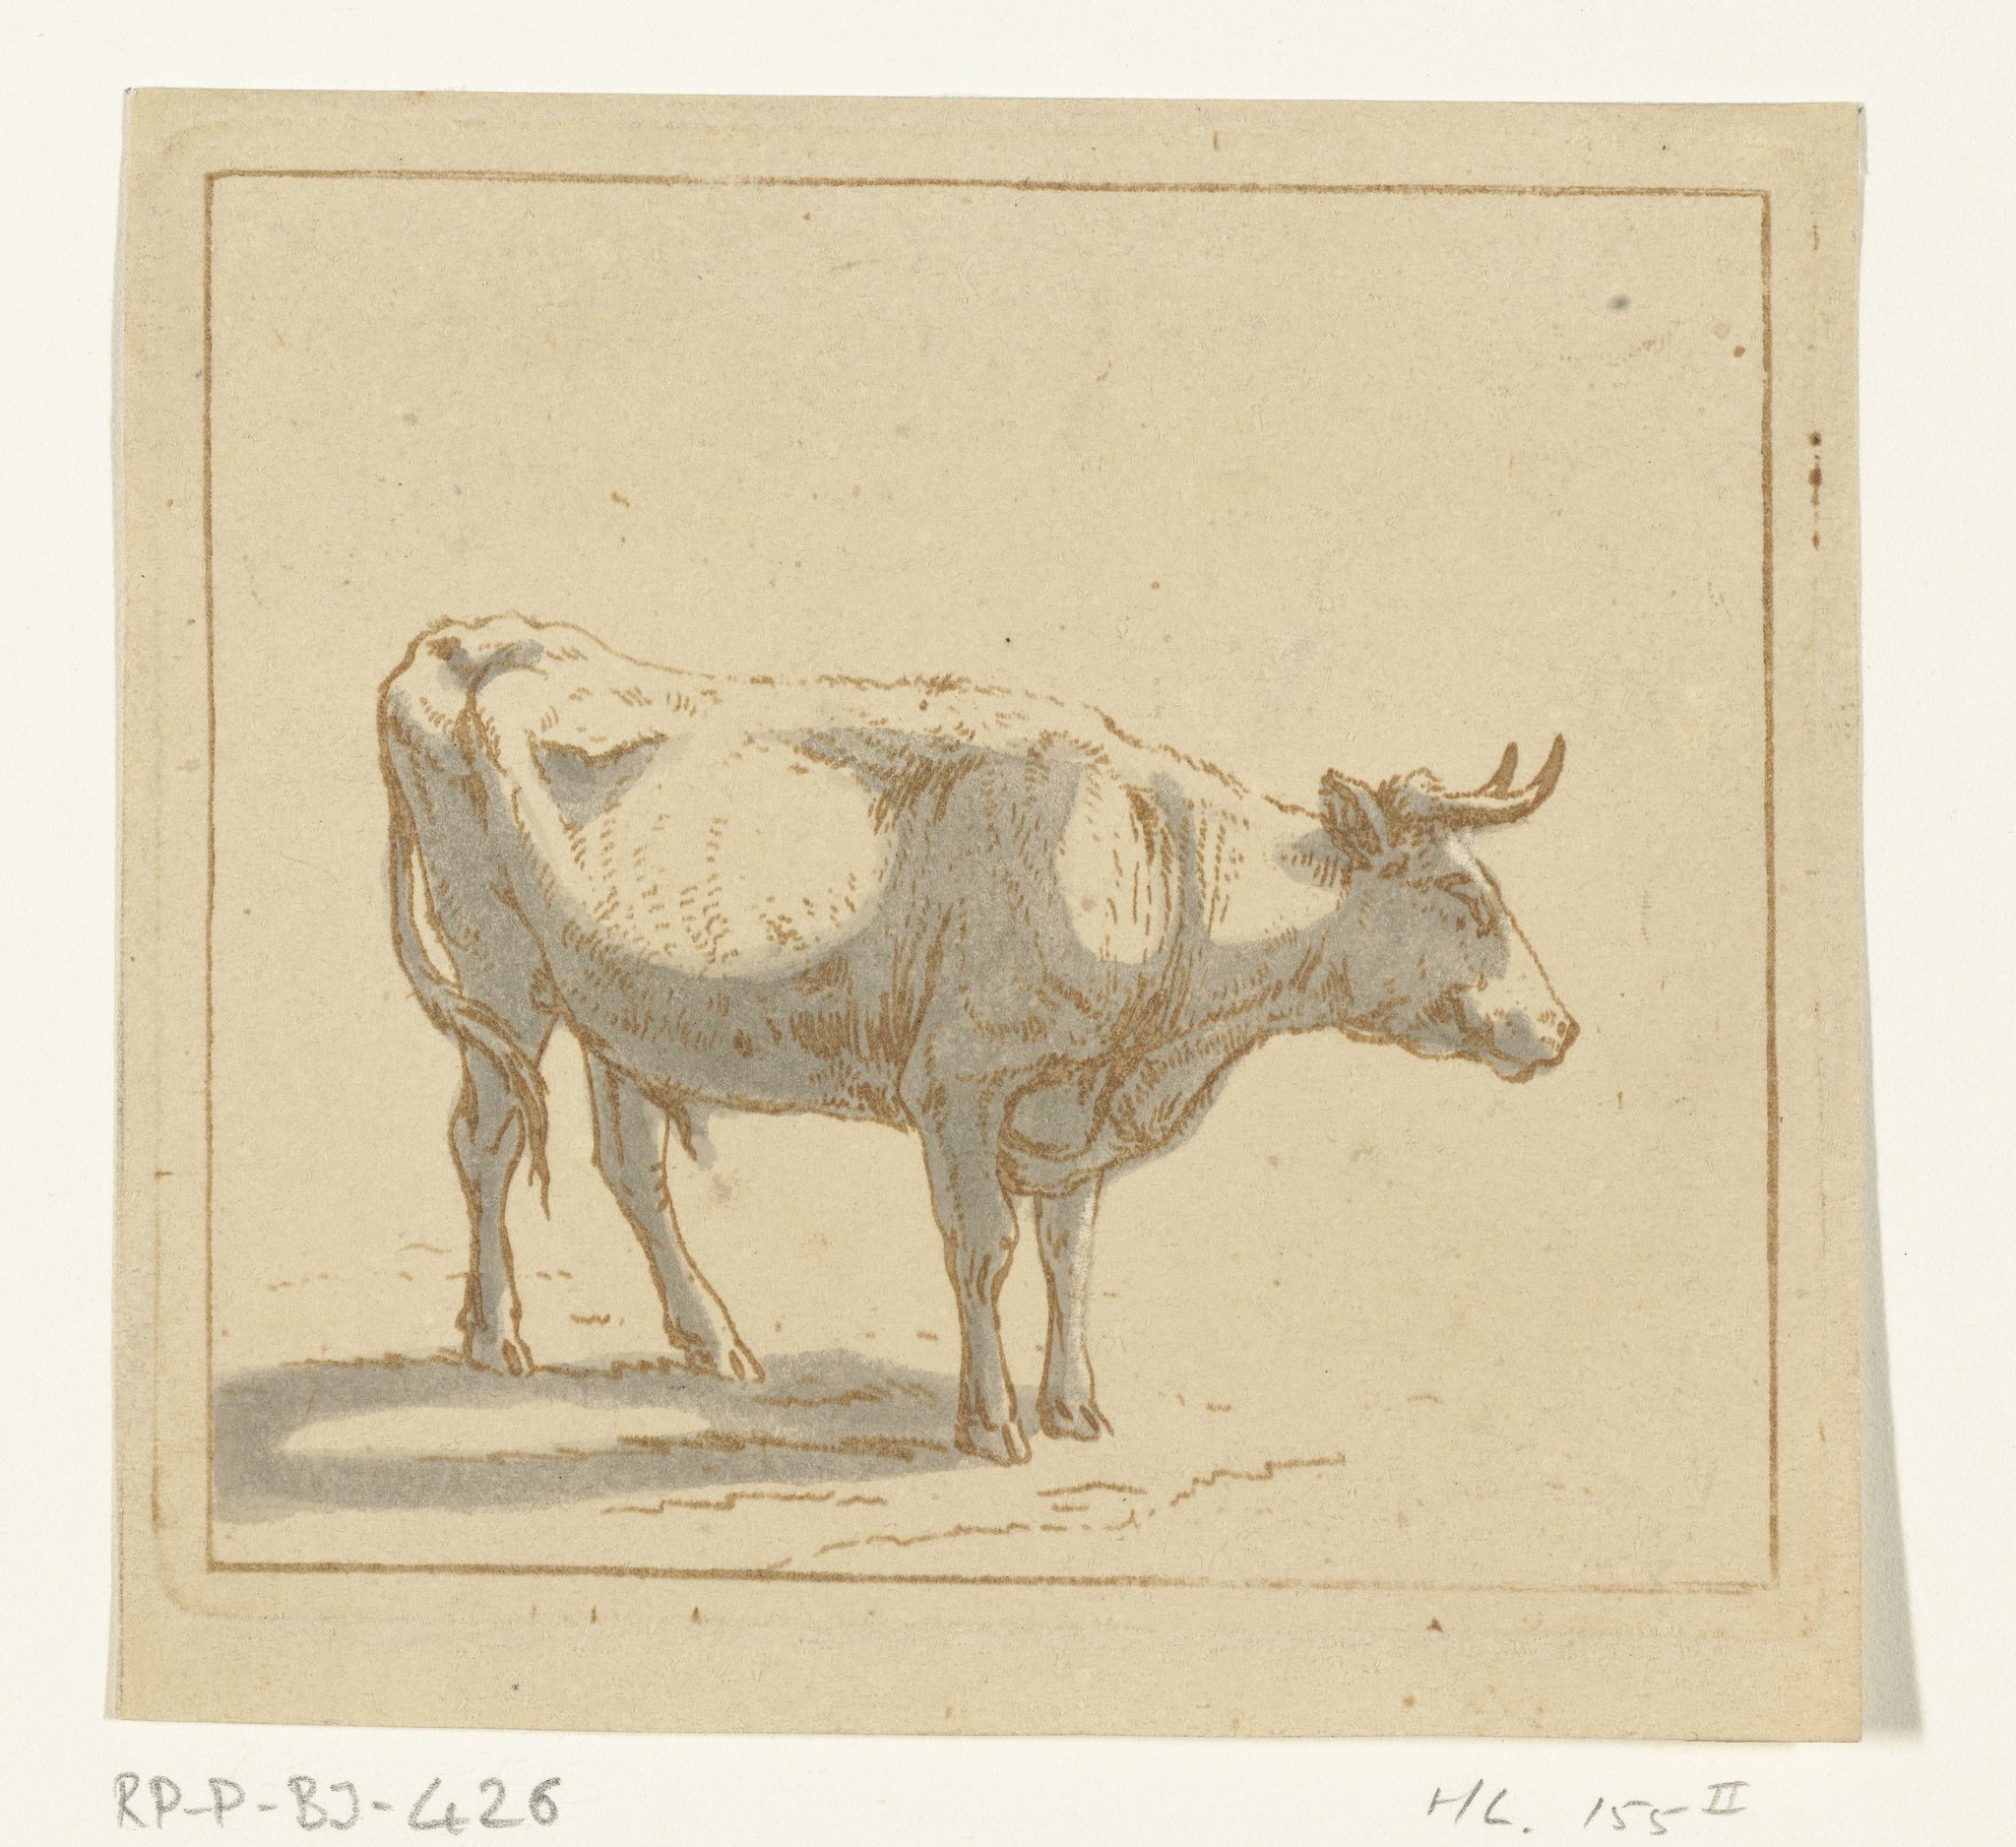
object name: print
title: Stier staand, naar rechts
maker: ernst willem jan bagelaar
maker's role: draughtsman, print maker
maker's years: 1775-1837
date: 1798-1837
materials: paper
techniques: printing, etching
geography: netherlands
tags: bull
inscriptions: inscription: ‘gedrukt met roest en oostindische inkt Bagelaar f’, collector's mark: Lugt 2228